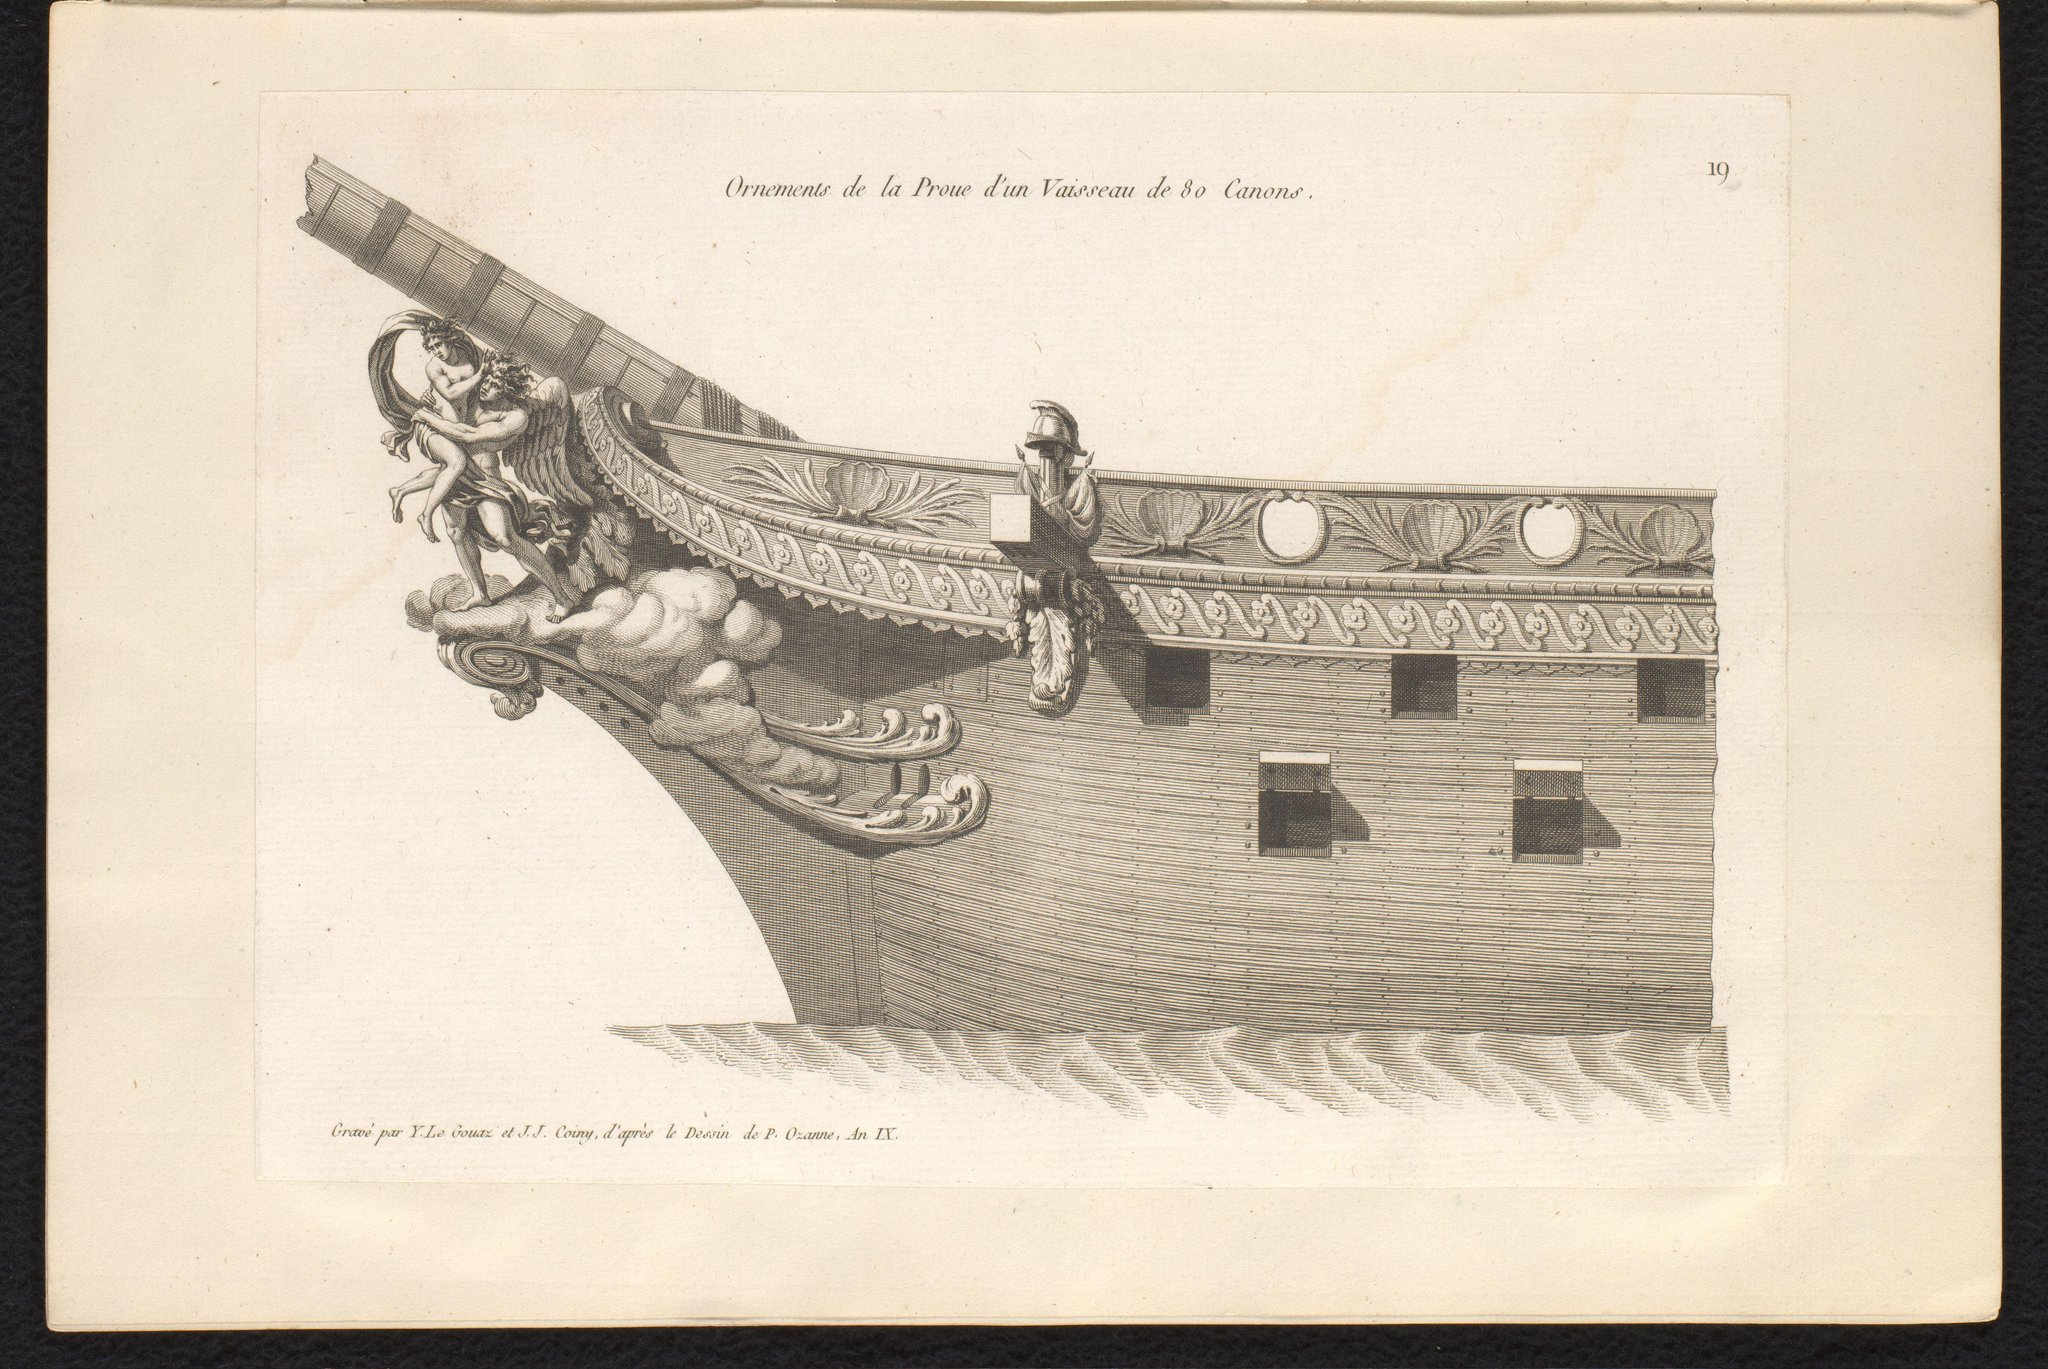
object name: album leaf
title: Ornements de la proue de différents vaisseaux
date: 1800-1801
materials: paper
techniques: engraving, etching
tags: sailing-ship, sailing-boat, parts of ship's exterior: bow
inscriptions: collector's mark: Lugt 2228, collector's mark: Lugt 2760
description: Deze prent maakt deel uit van een album.